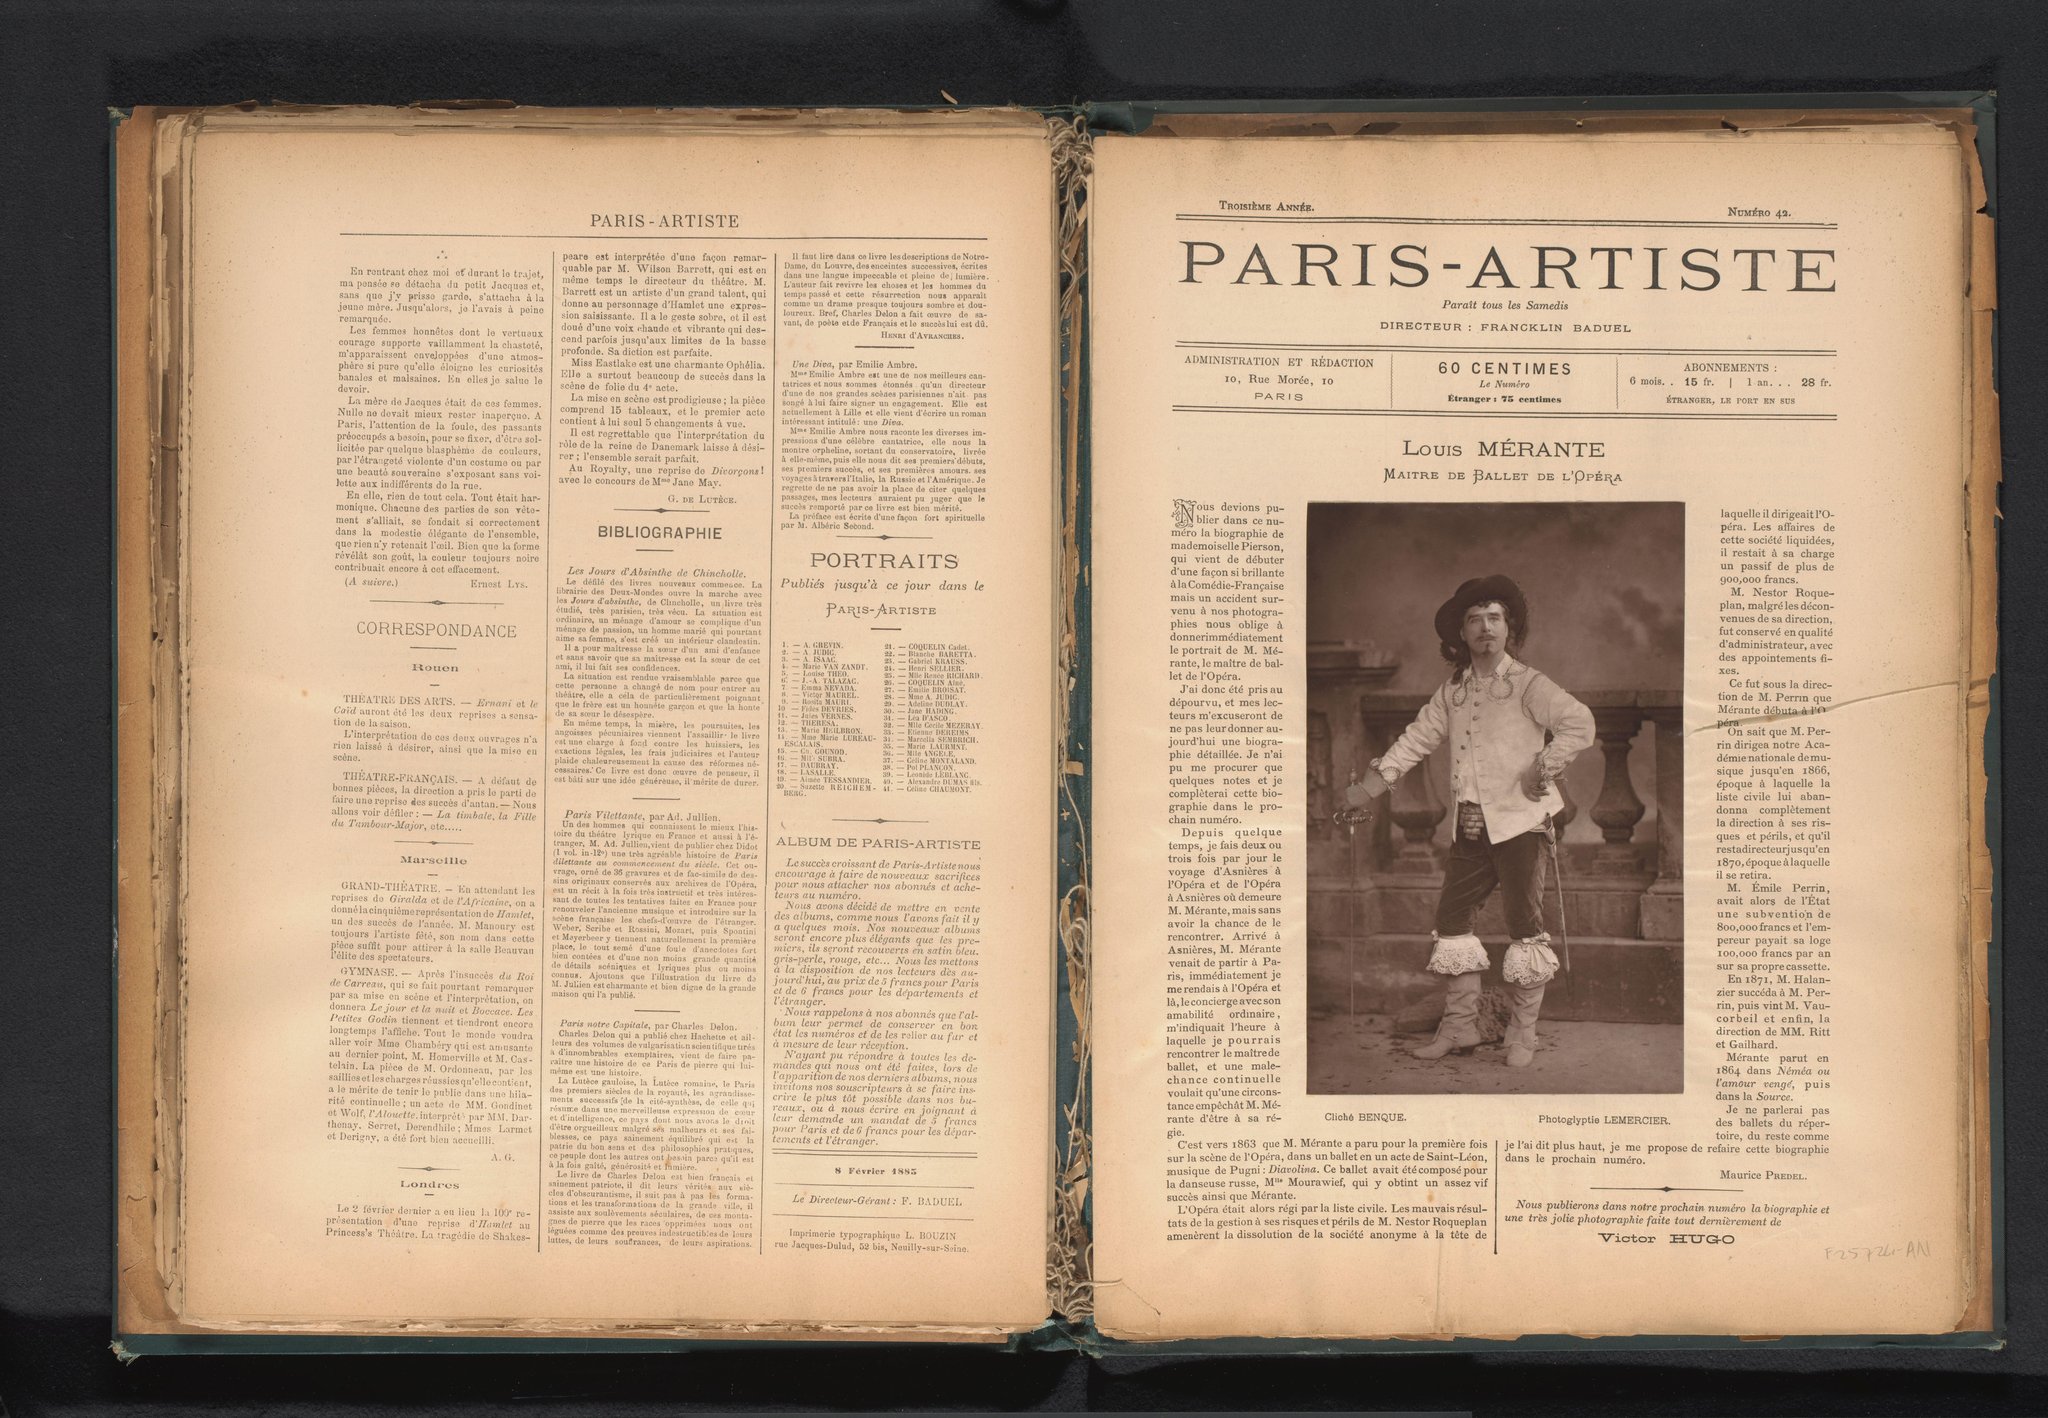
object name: page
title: Portret van Louis Mérante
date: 1875-1885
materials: paper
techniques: woodburytype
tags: paris, choreographer, historical persons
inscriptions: inscription: ‘Maitre de Ballet de l'Opera’